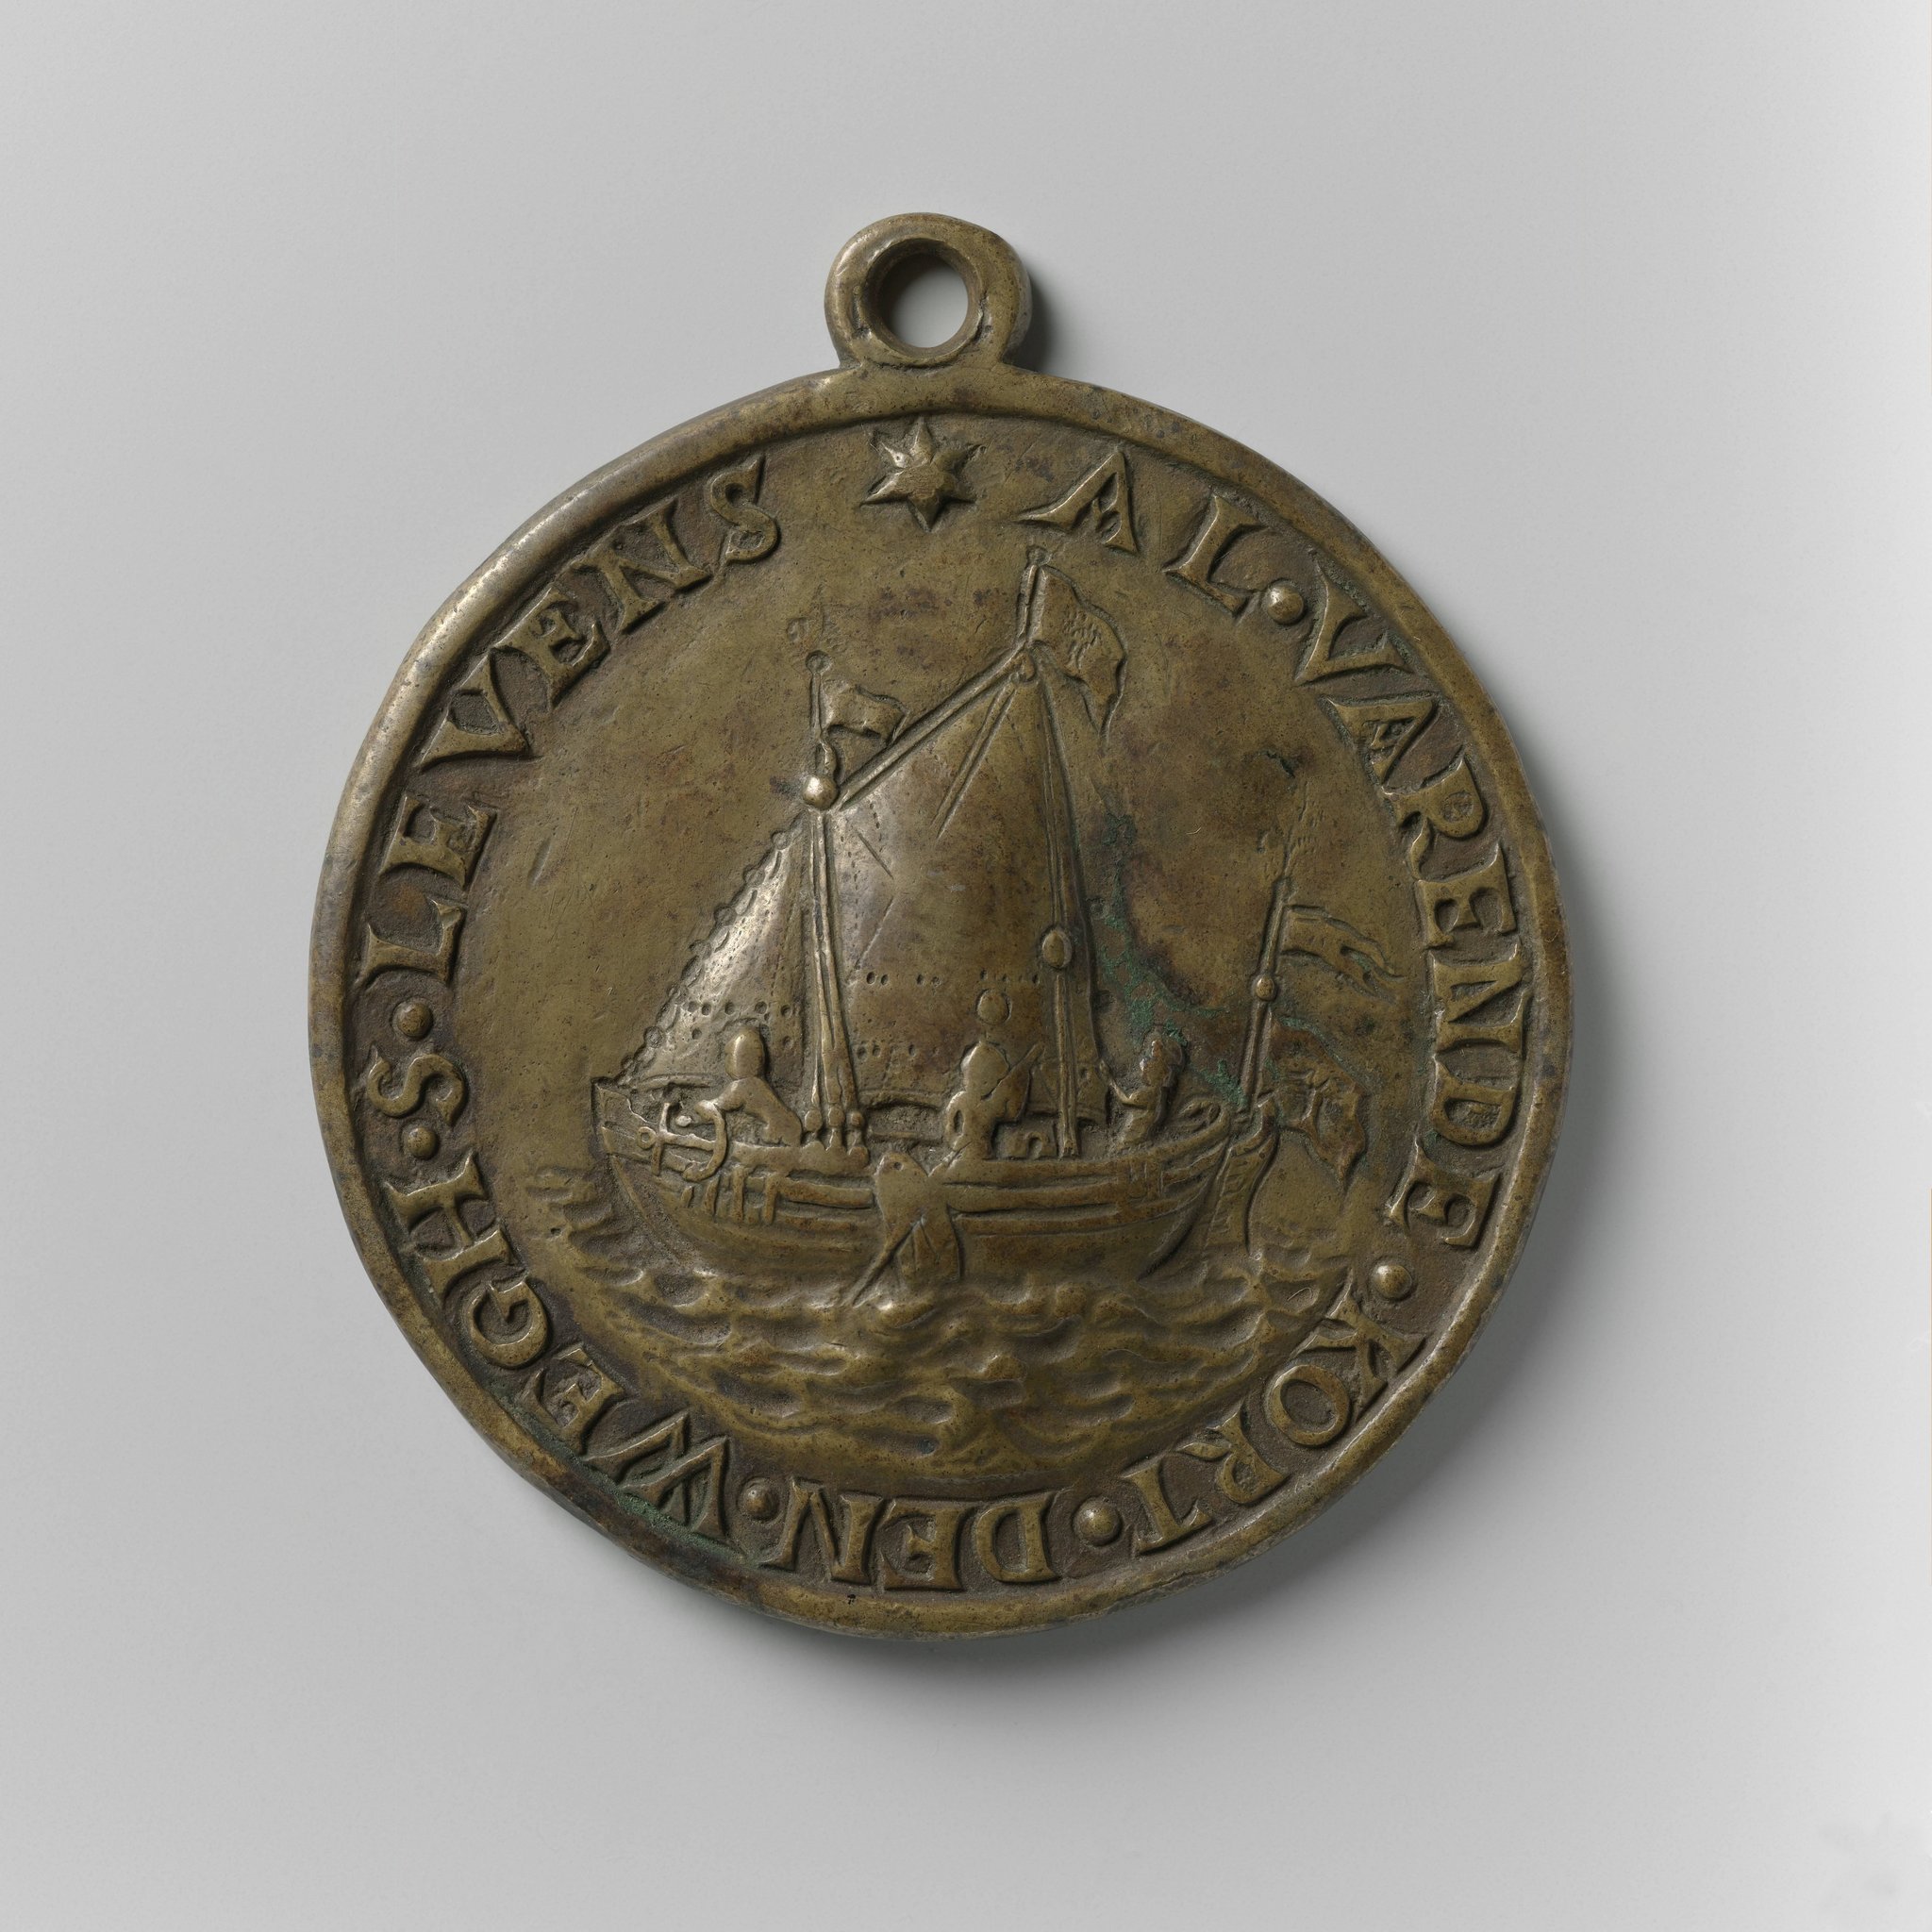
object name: medal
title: Schippersgilde van 's-Hertogenbosch, gildepenning met no. 39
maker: Anonymous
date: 1683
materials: brass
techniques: casting, engraving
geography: den bosch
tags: den bosch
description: Messing penning aan draagoog. Voorzijde: naar links varende tjalk met driekoppige bemanning binnen omschrift. Keerzijde: boom, geflankeerd door cijfers 3 en 9 onder jaartal binnen omschrift